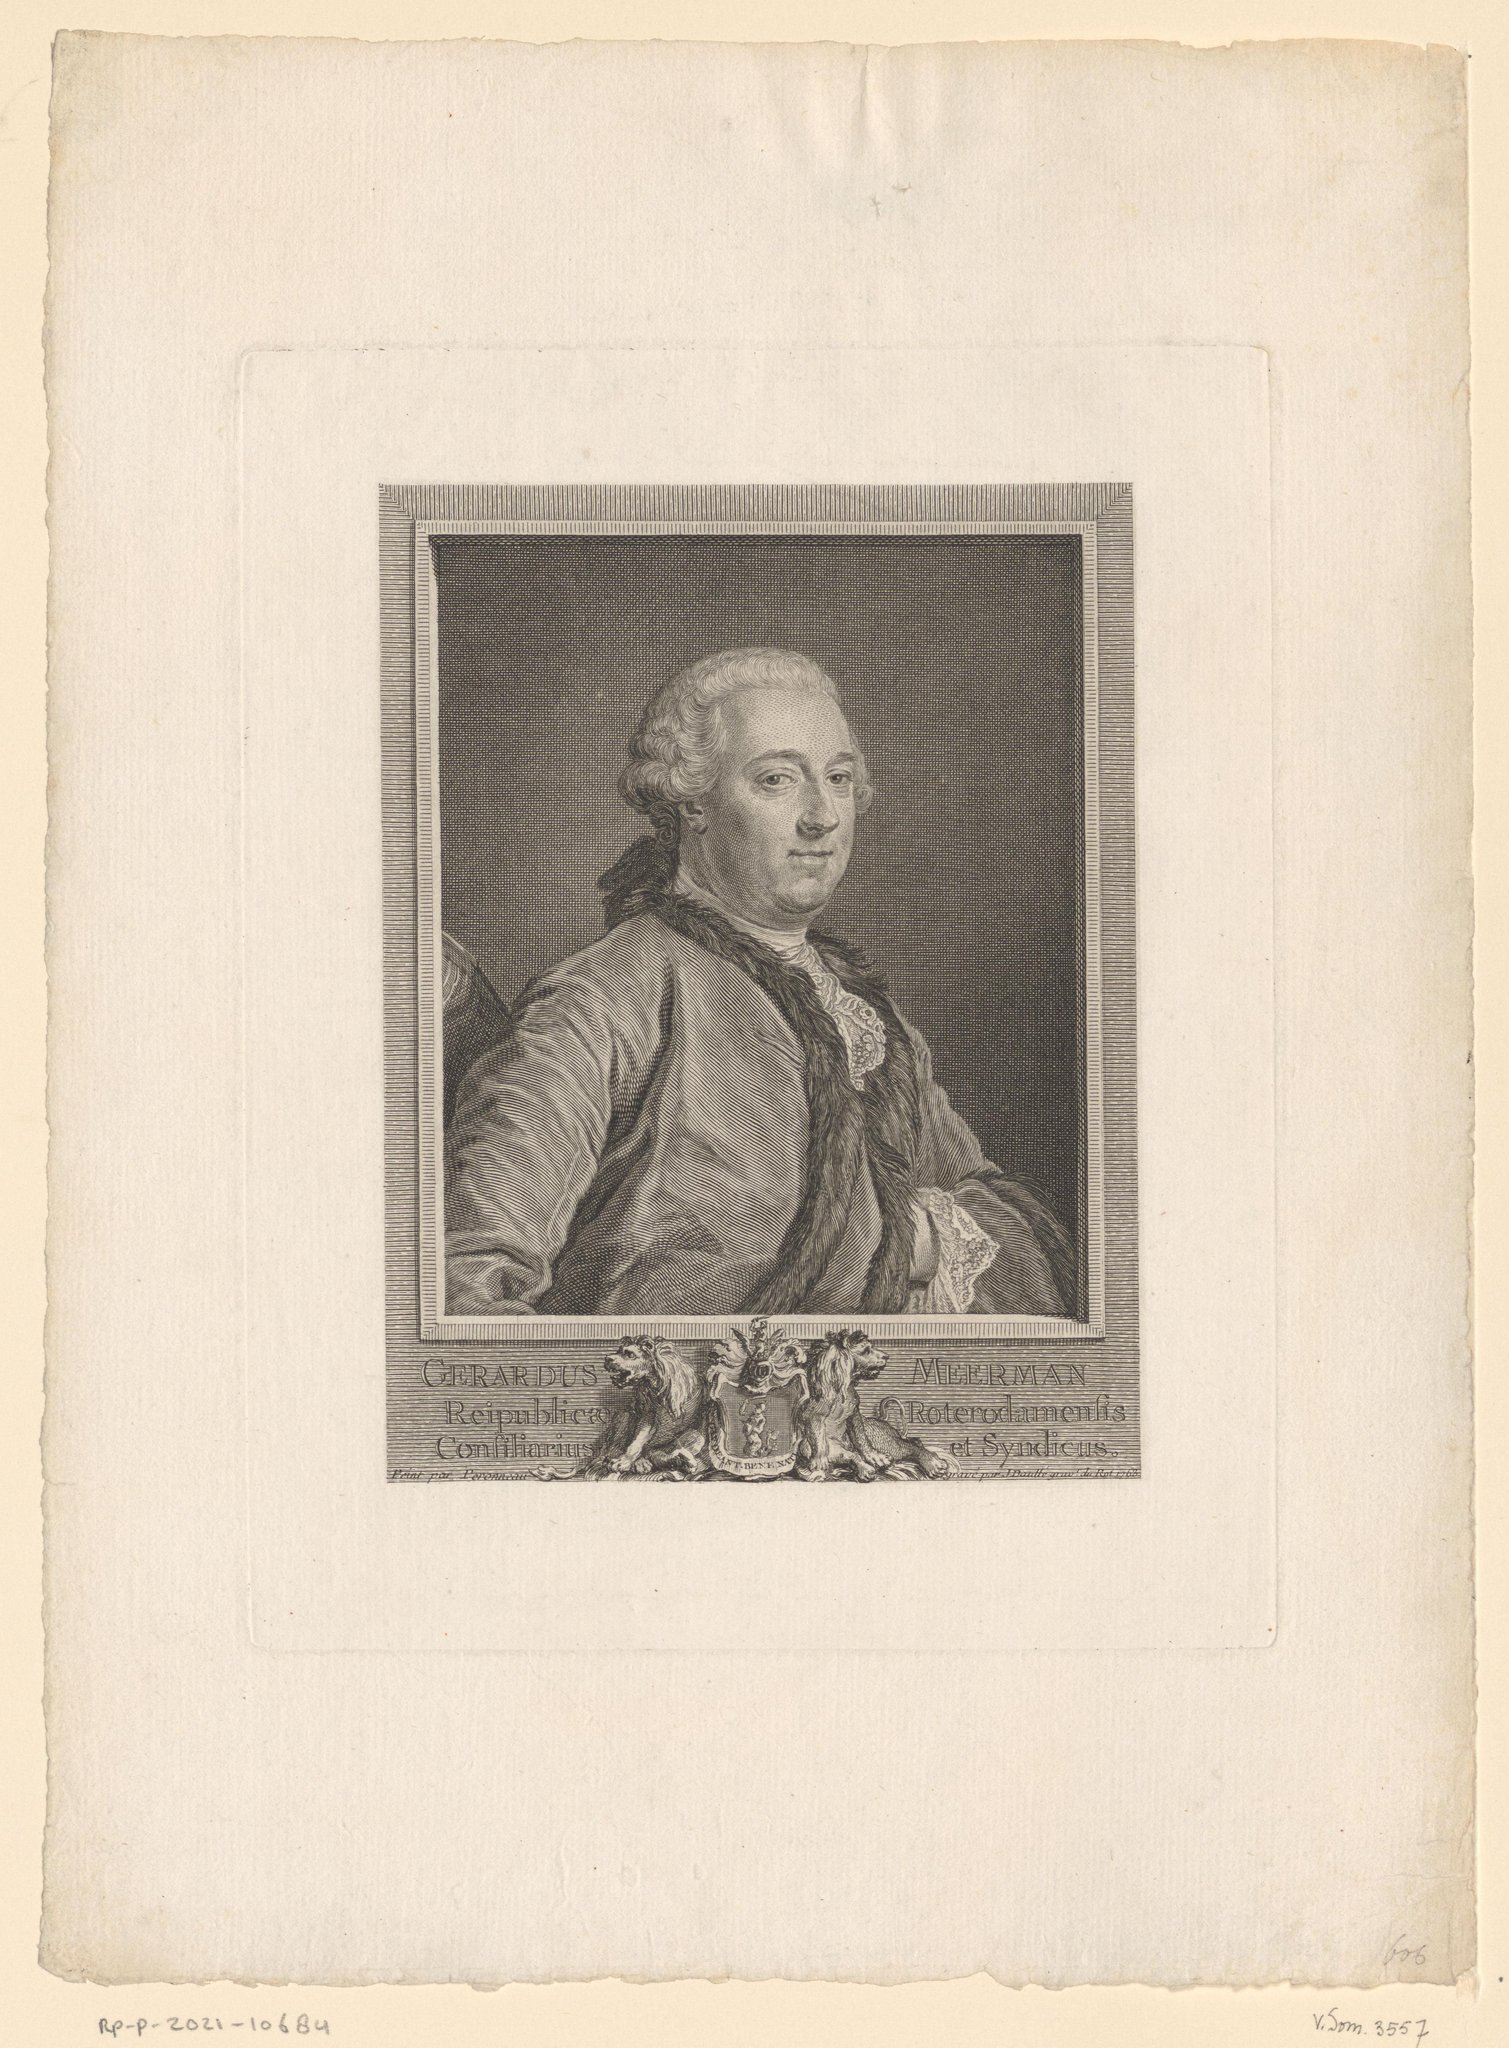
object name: print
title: Portret van Gerard Meerman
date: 1763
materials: paper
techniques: engraving, etching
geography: france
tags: official; civil servant; functionary (in general), historical persons, armorial bearing, heraldry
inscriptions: inscription: ‘8/4/ 08’